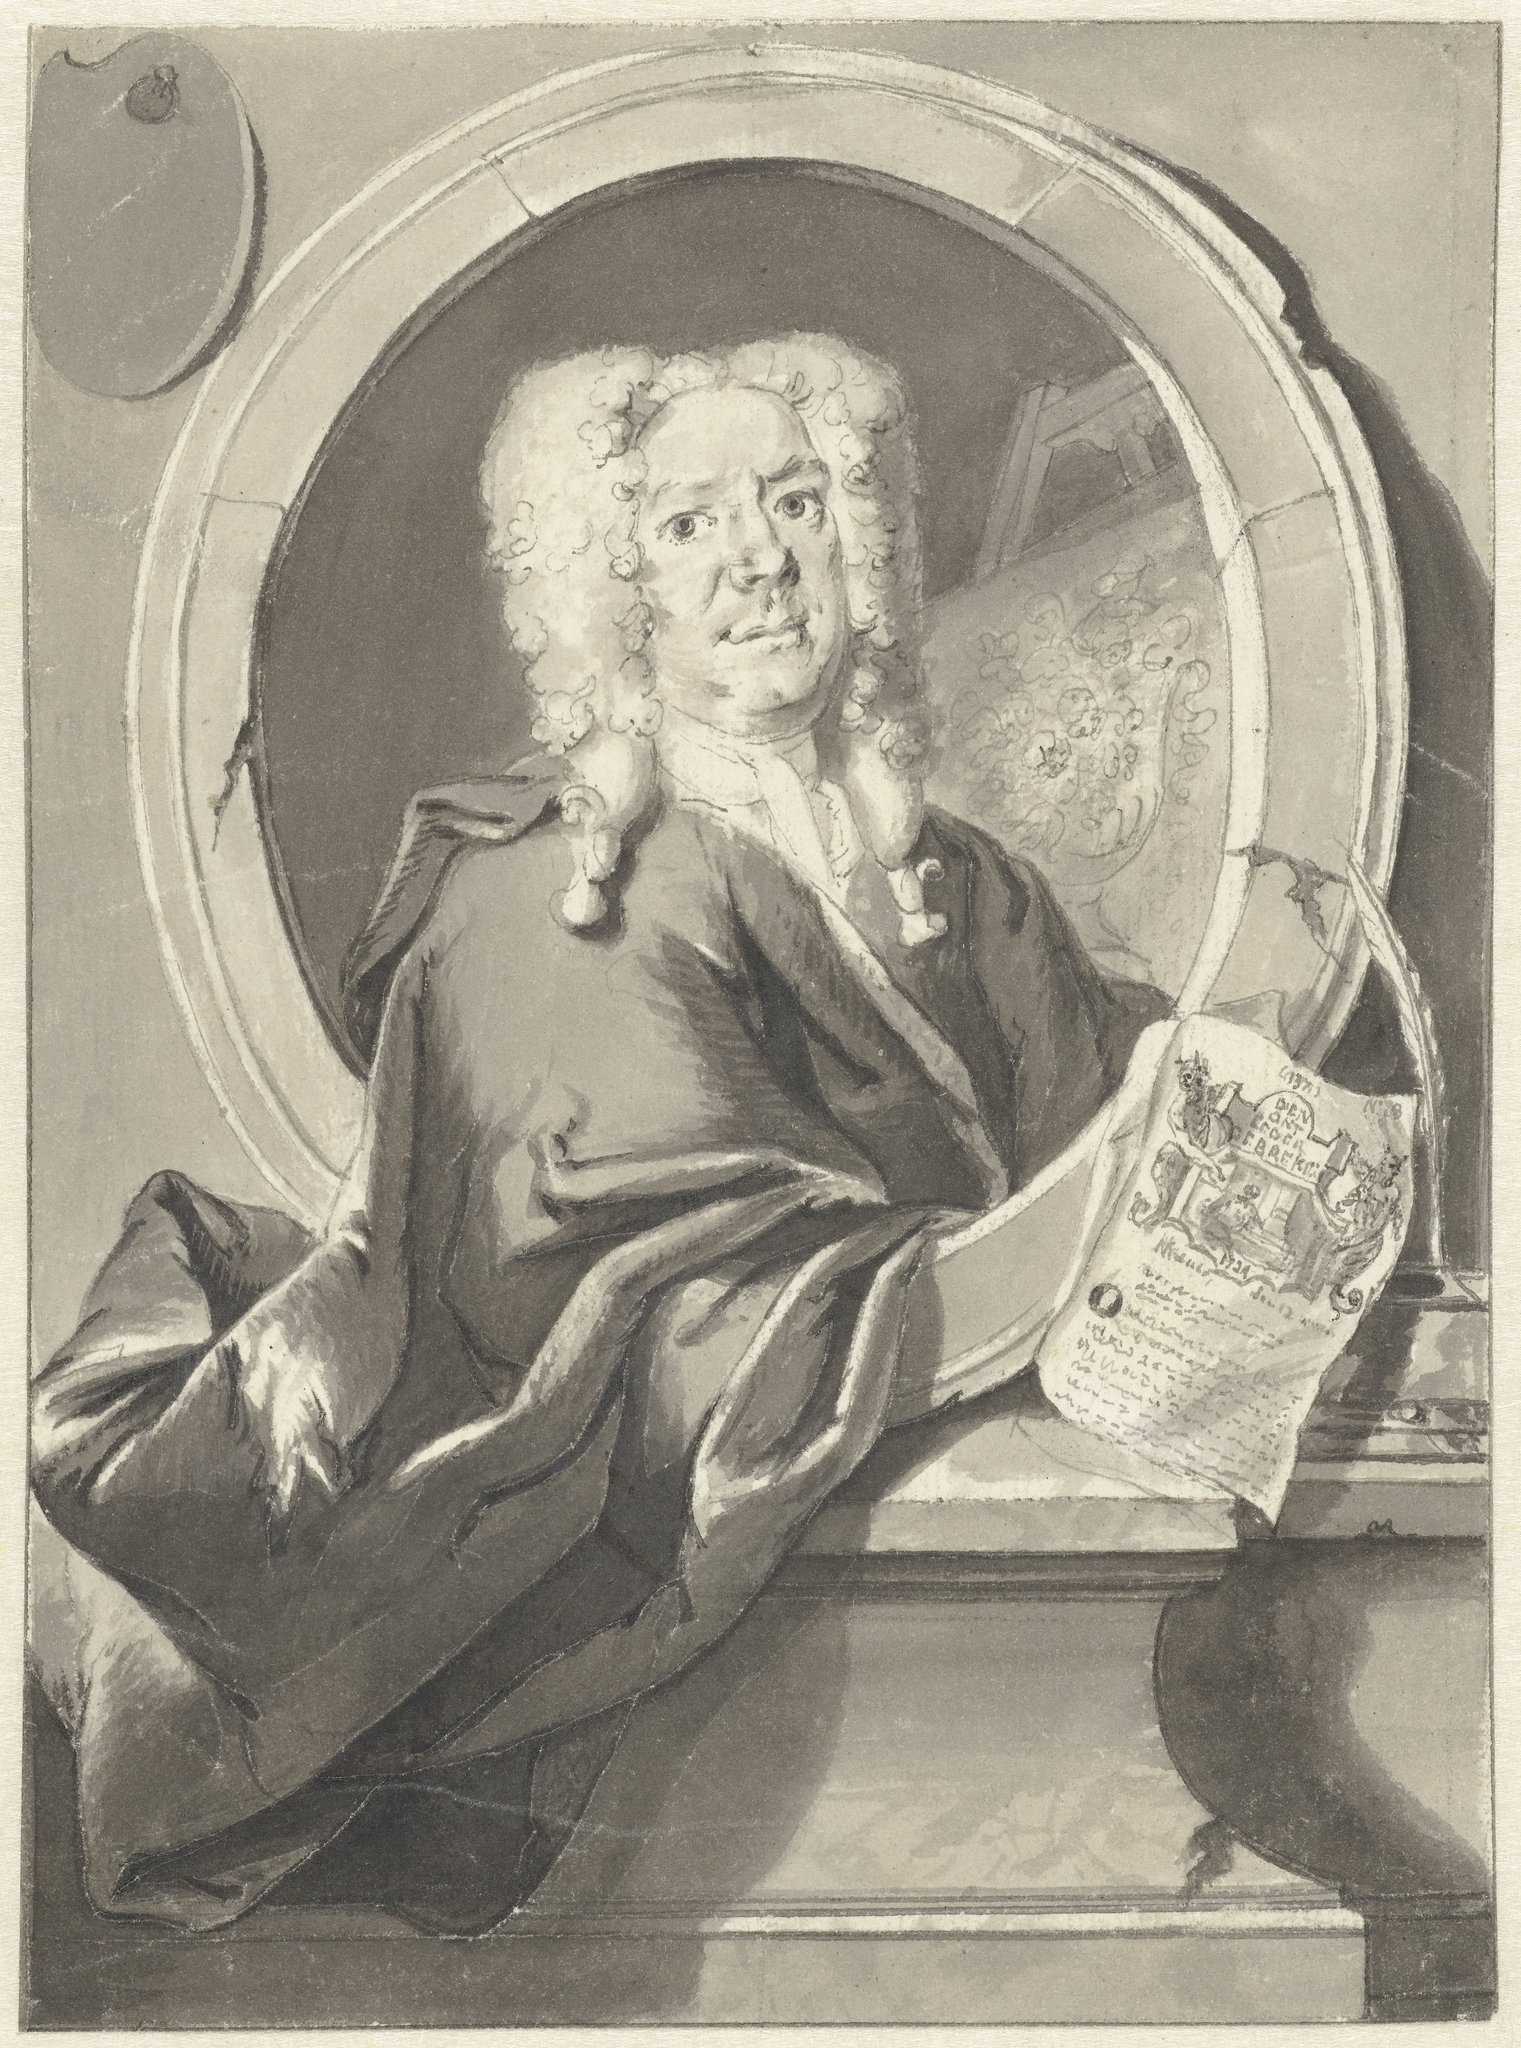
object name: drawing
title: Portret van Jacob Campo Weyerman in medaillon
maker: cornelis troost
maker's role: draughtsman, painter, print maker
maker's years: 1696-1750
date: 1706-1750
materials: ink, paper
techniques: brush, pen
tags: the hague, jacob campo weyerman, historical persons, portrait, self-portrait of artist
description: Papiertje met opschrift `Den Ont Leder de[r Ge]Breken'.